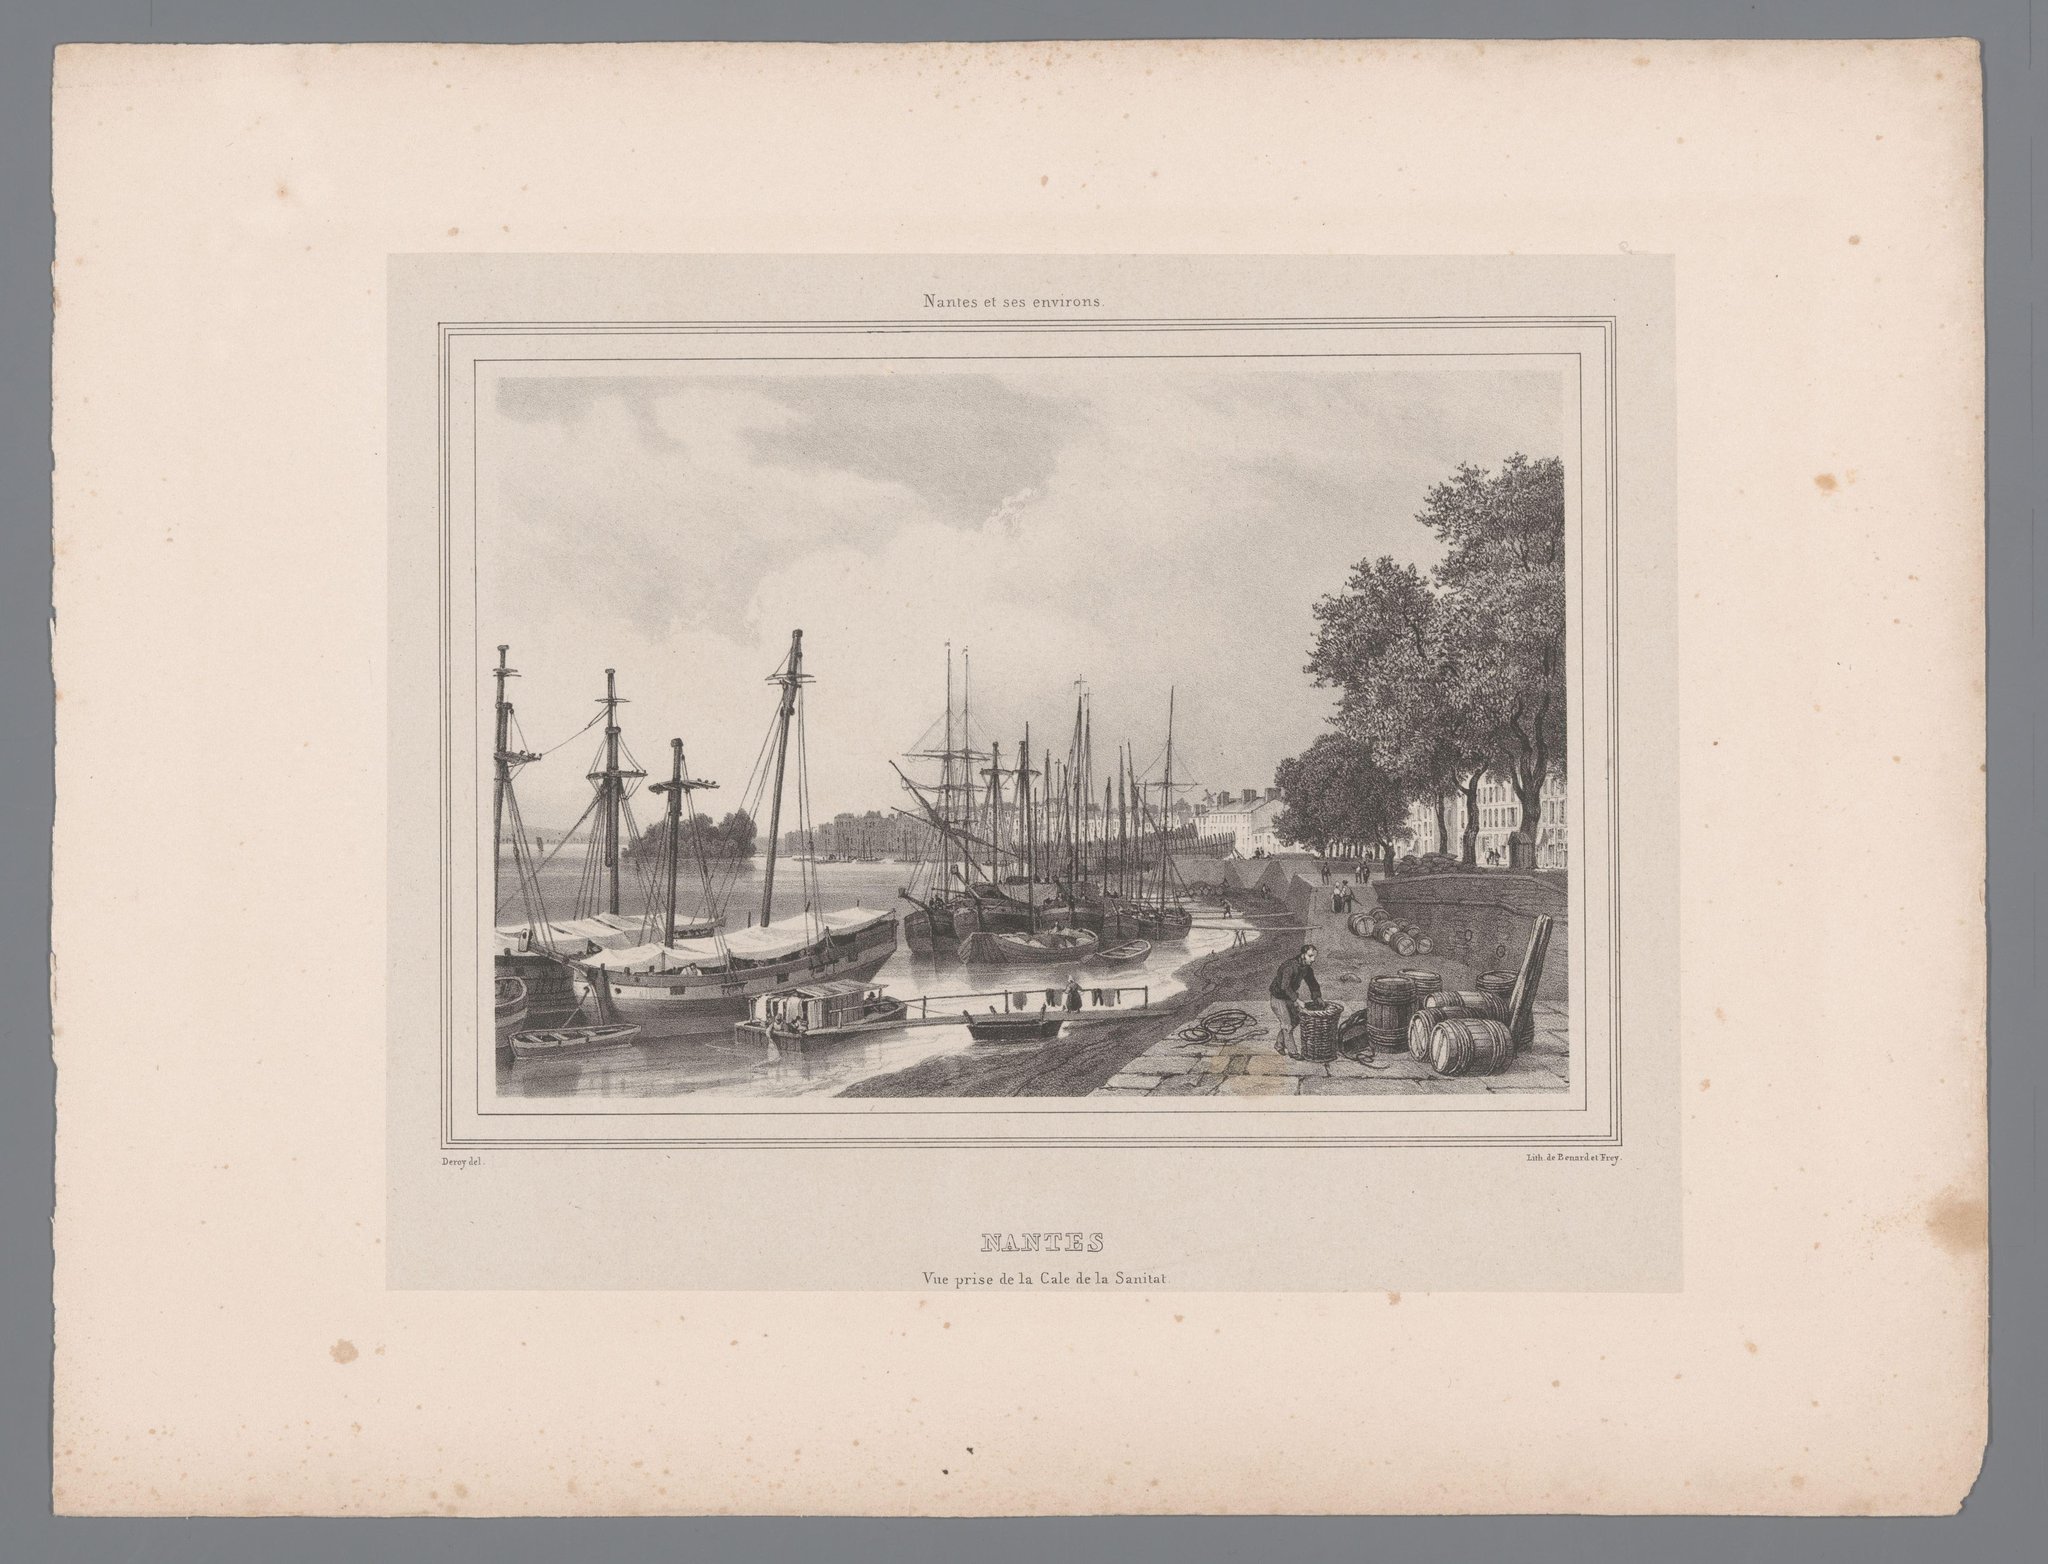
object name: print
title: Zicht op de Loire vanaf de kade van het Sanitat in Nantes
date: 1833-1835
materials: paper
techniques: lithograph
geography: paris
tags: ships (in general), river (+ landscape with figures, staffage), prospect of city, town panorama, silhouette of city (+ city(-scape) with figures, staffage)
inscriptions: collector's mark: Lugt 2228a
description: Prent maakt deel uit van een omslag met achttien prenten.